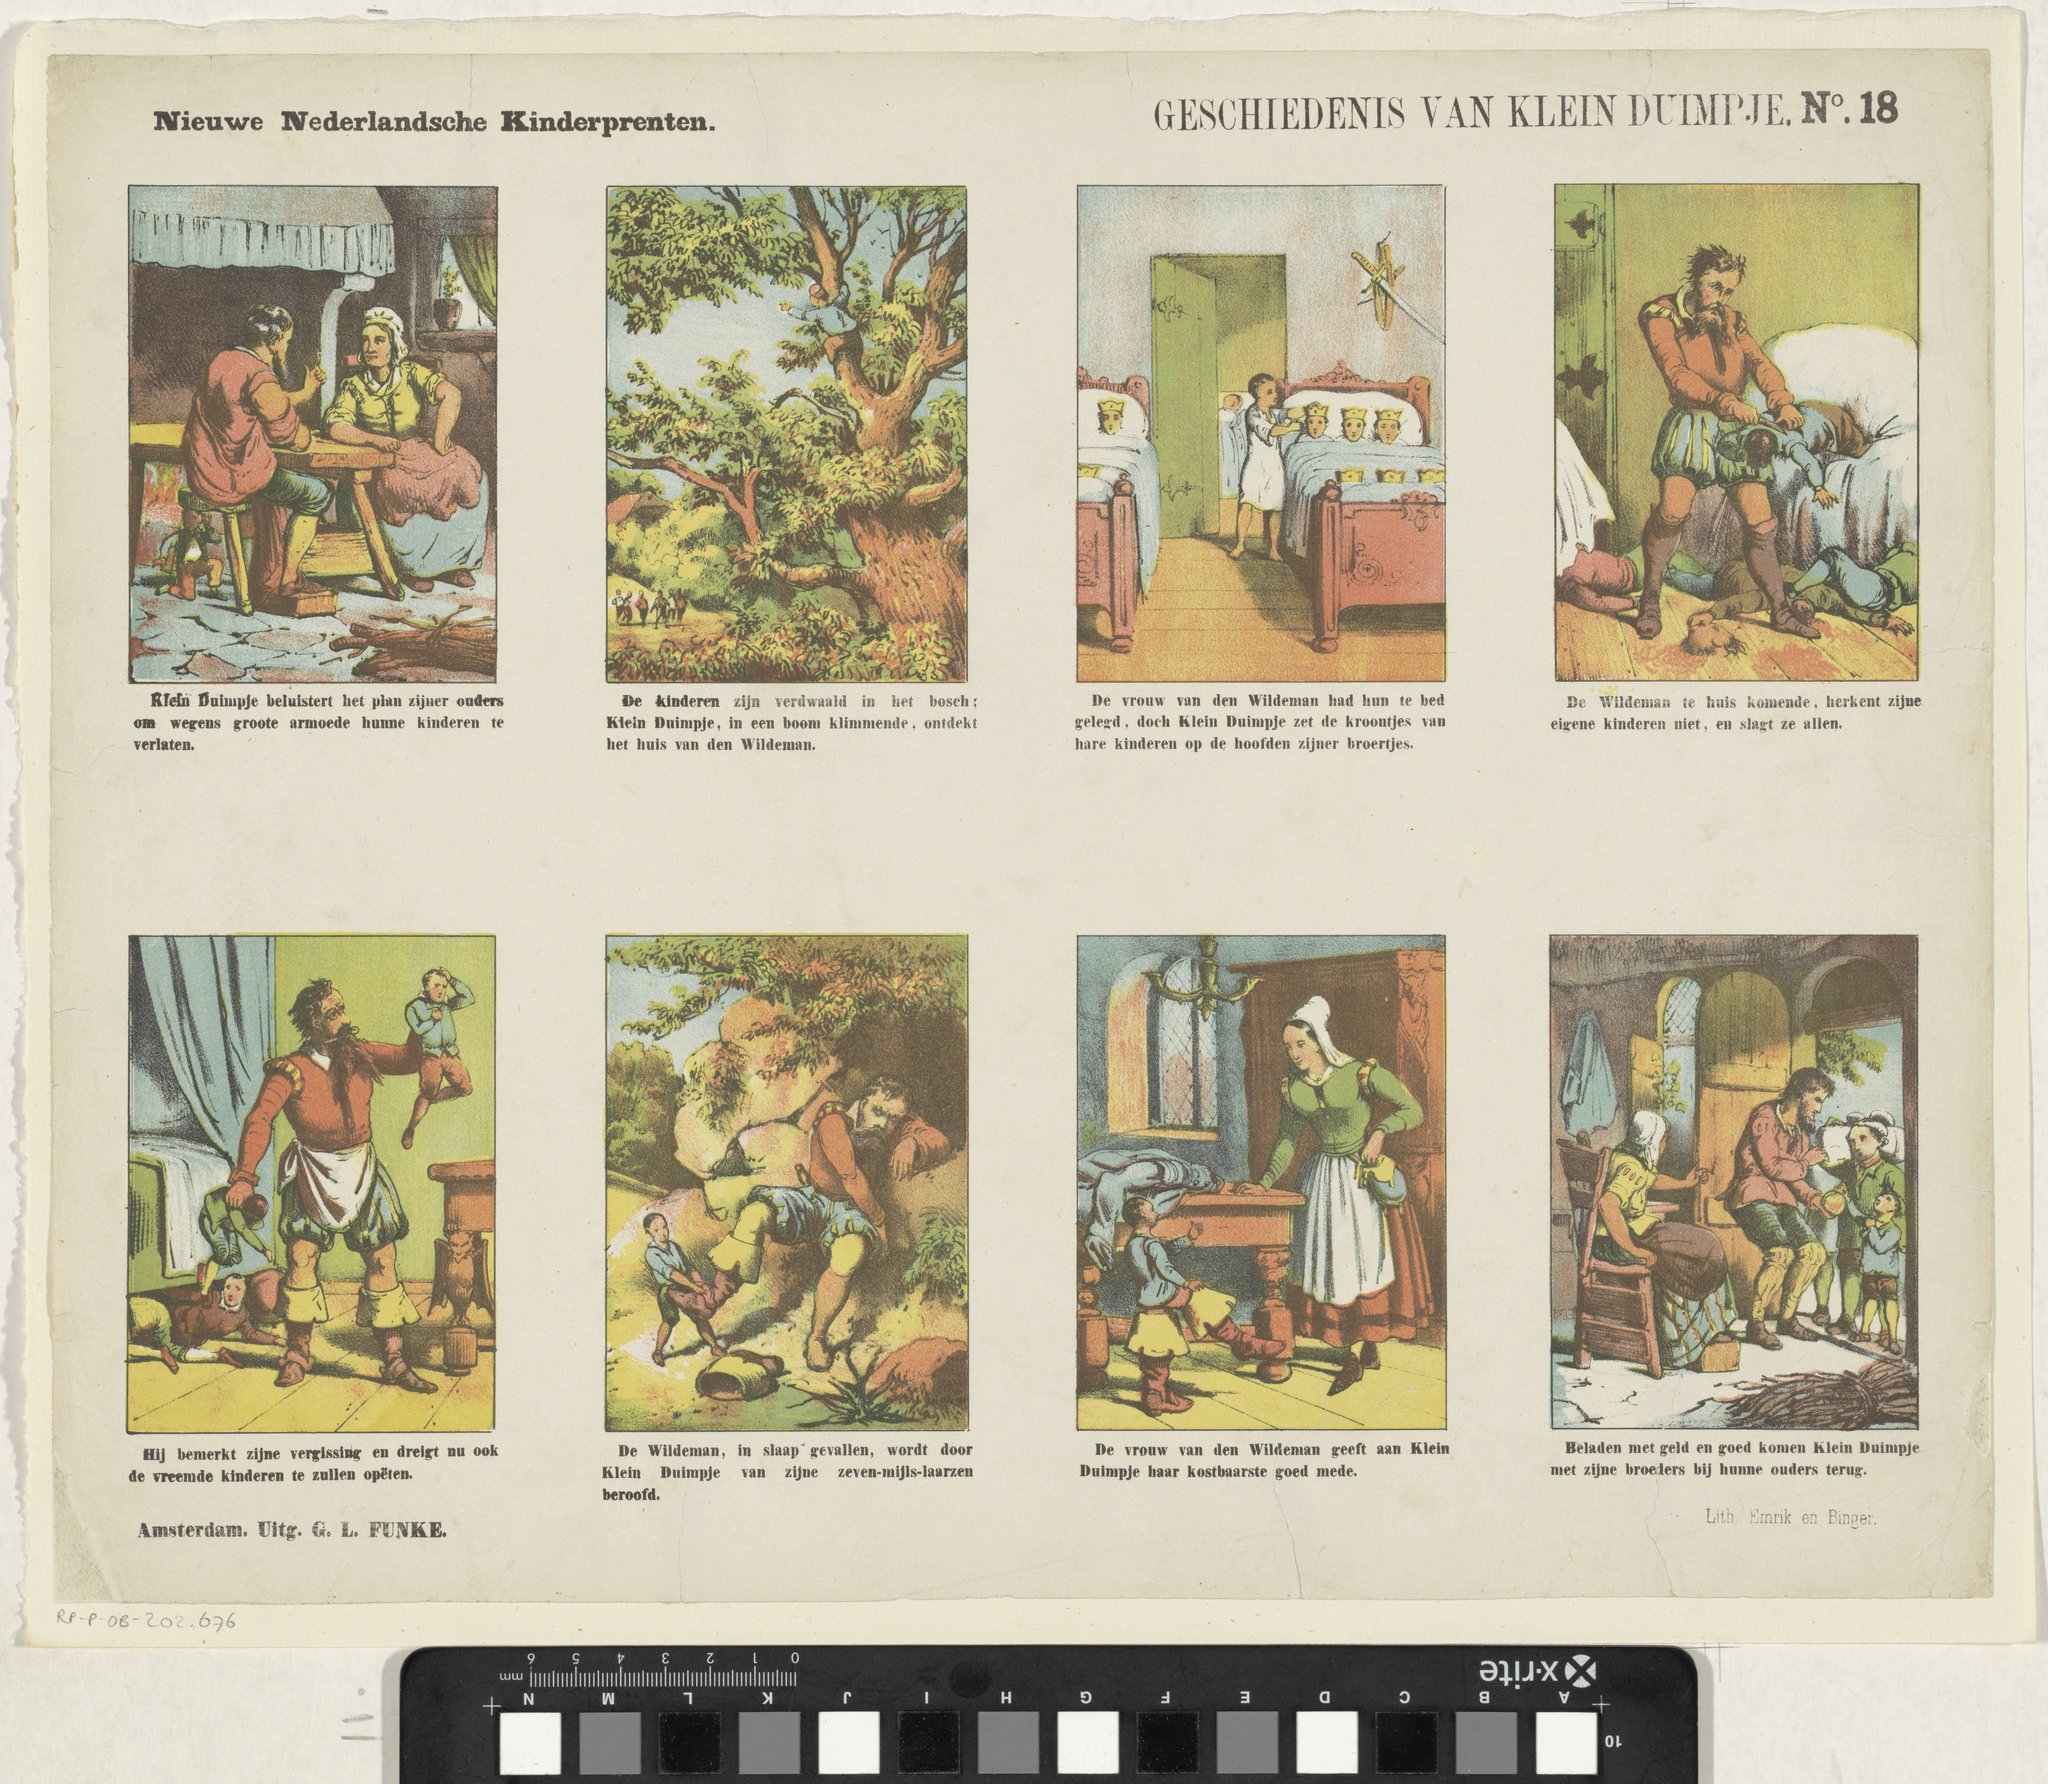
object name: popular print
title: Nieuwe Nederlandsche kinderprenten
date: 1865-1875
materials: paper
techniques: lithograph, letterpress printing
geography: amsterdam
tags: tales and fairy tales: little thumbling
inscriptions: collector's mark: Lugt 2760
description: Blad met 8 voorstellingen uit het sprookje van Klein Duimpje. Onder elke afbeelding een onderschrift. Genummerd rechtsboven: No. 18.